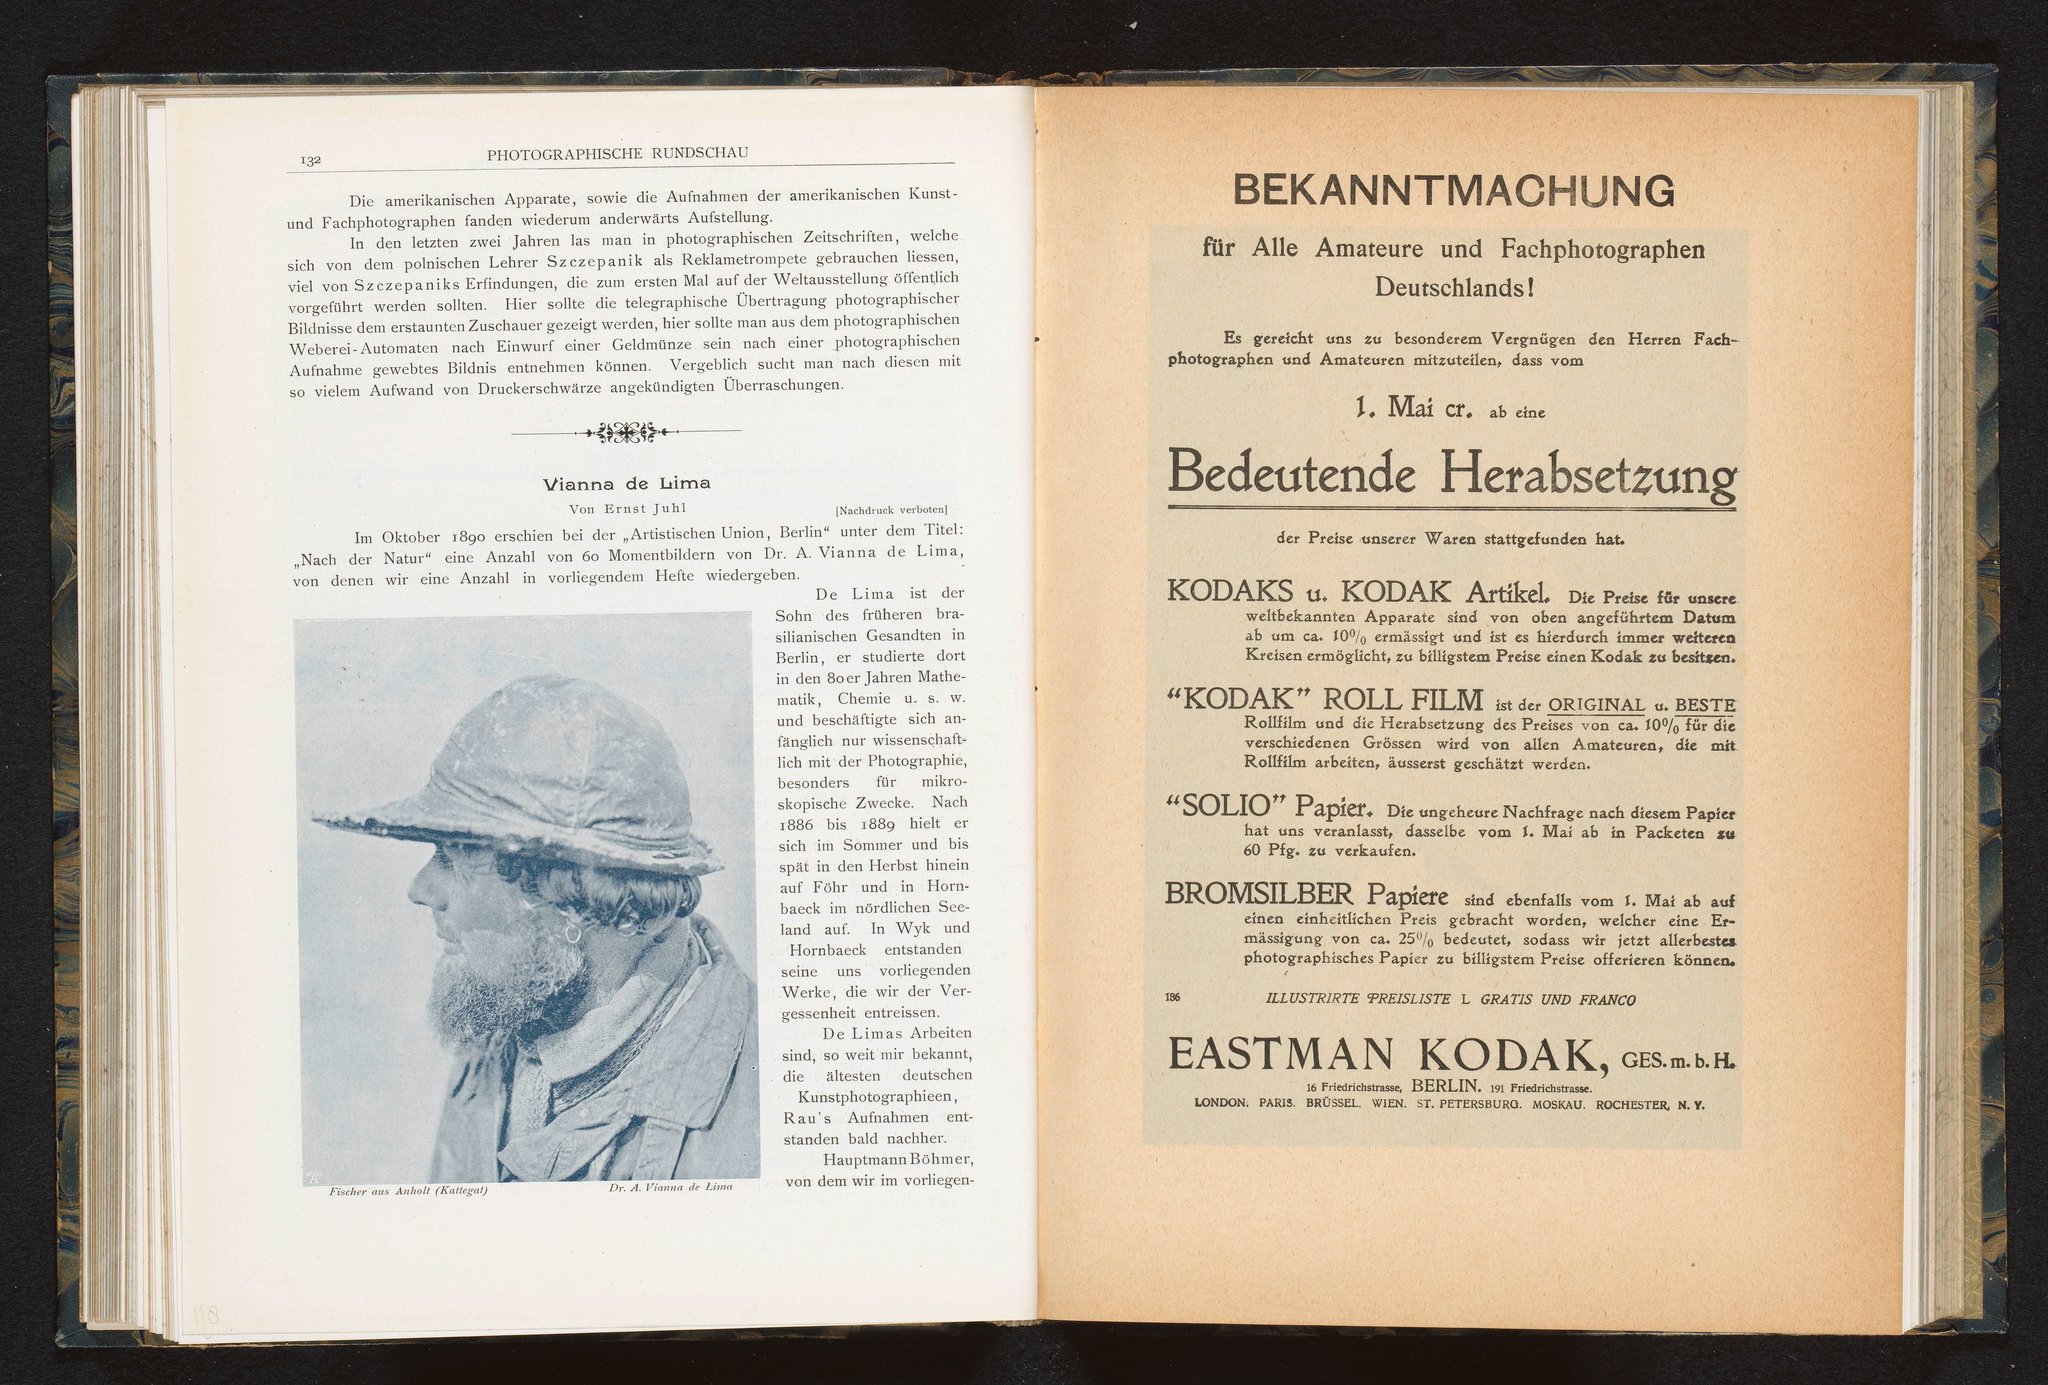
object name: photomechanical print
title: Portret van een visser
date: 1895-1900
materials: paper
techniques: autotype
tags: fisherman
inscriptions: monogram: ‘drAco’